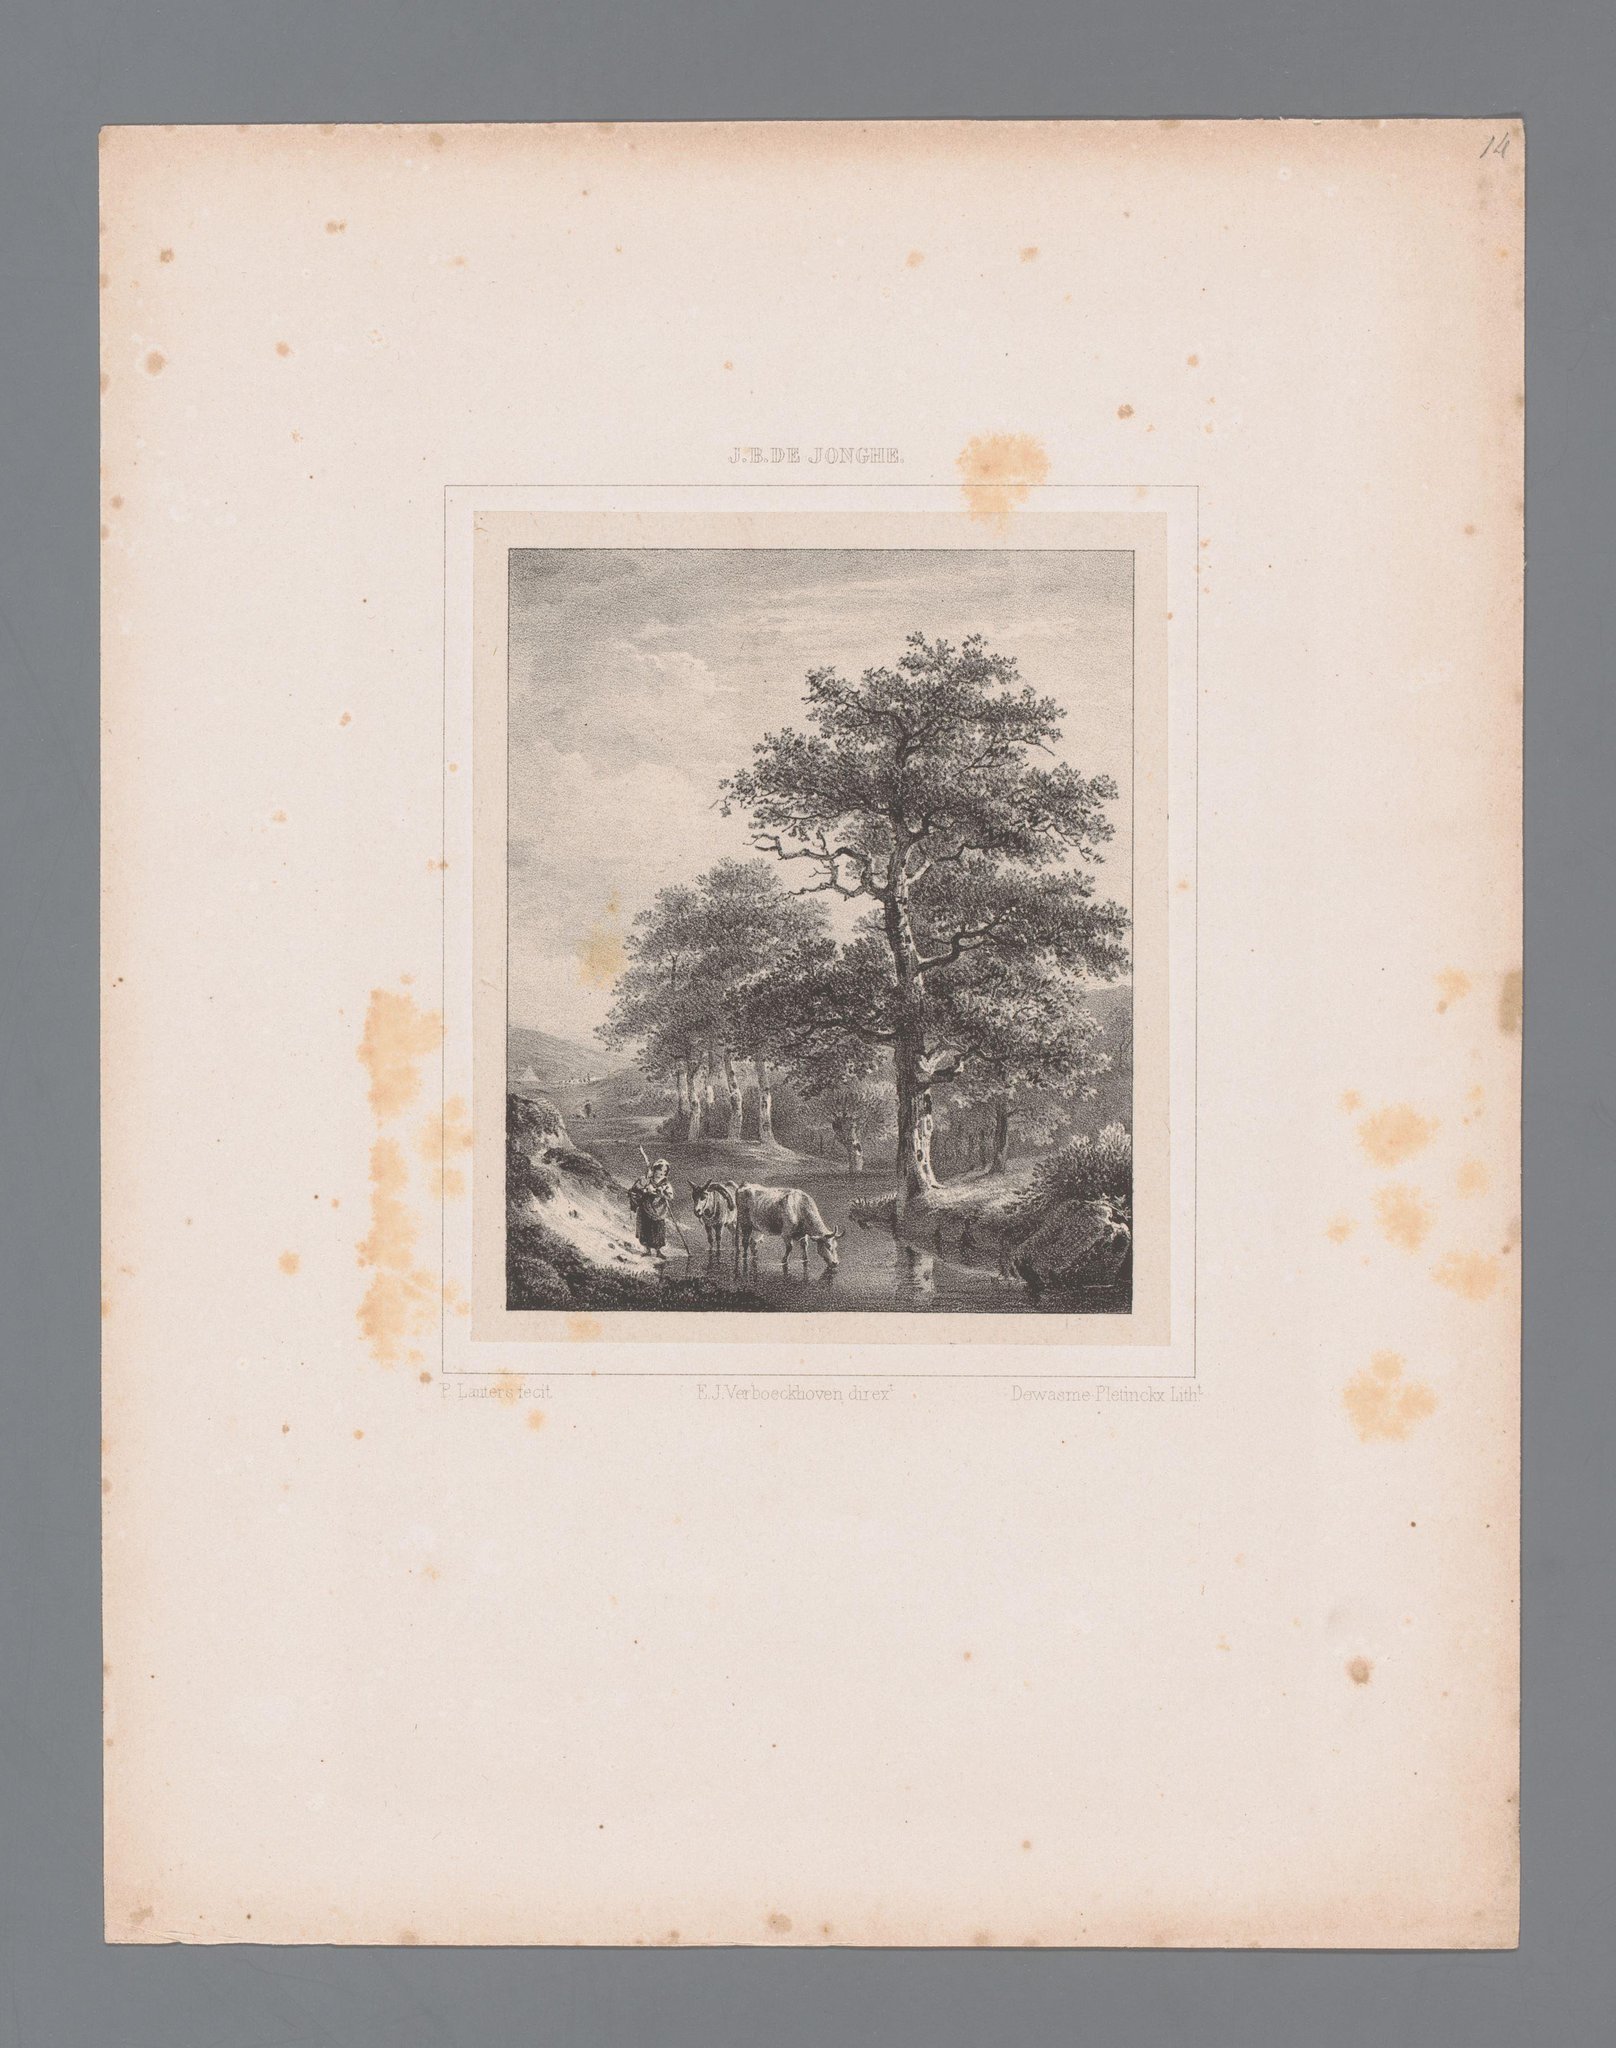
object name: print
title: J.B. De Jonghe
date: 1829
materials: paper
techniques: lithograph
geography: brussels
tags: cow (+ animals eating and drinking), landscapes with waters, waterscapes, seascapes (in the temperate zone)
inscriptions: collector's mark: Lugt 2233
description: Prent verschenen in: Verboeckhoven, Eugène. Album lithographié par Paul Lauters d'après les dessins des principaux peintres du Royaume des Pays-Bas. Brussel: Antoine Dewasme-Pletinckx, 1829.